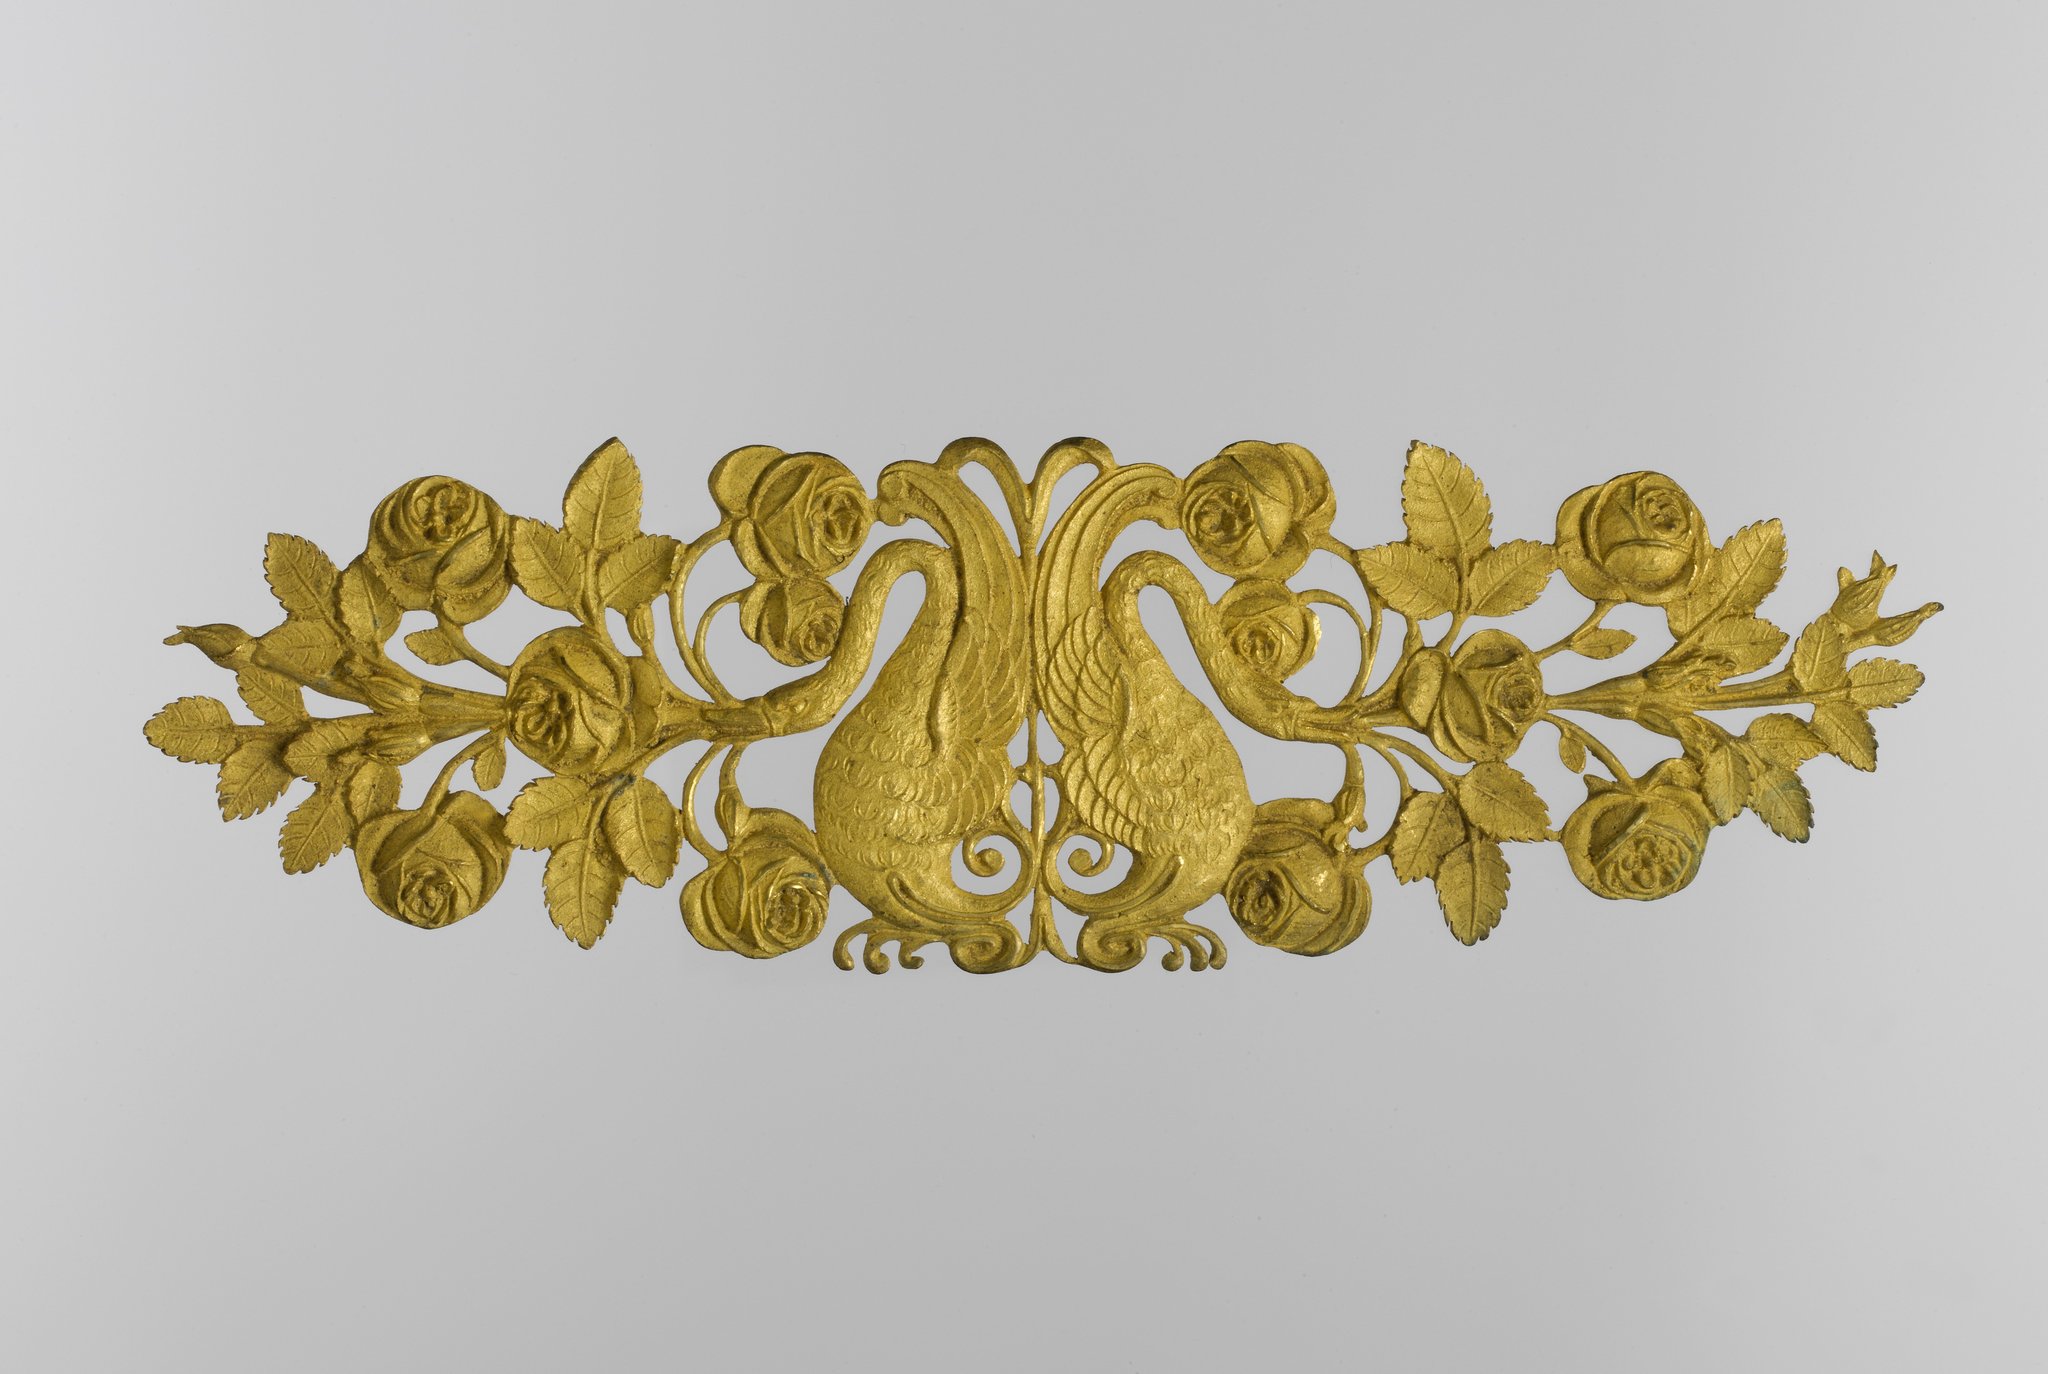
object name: furniture hardware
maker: henry kellam hancock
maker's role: retailer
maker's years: 1816-1851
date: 1820-1830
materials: brass, gilt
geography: france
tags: swans,roses